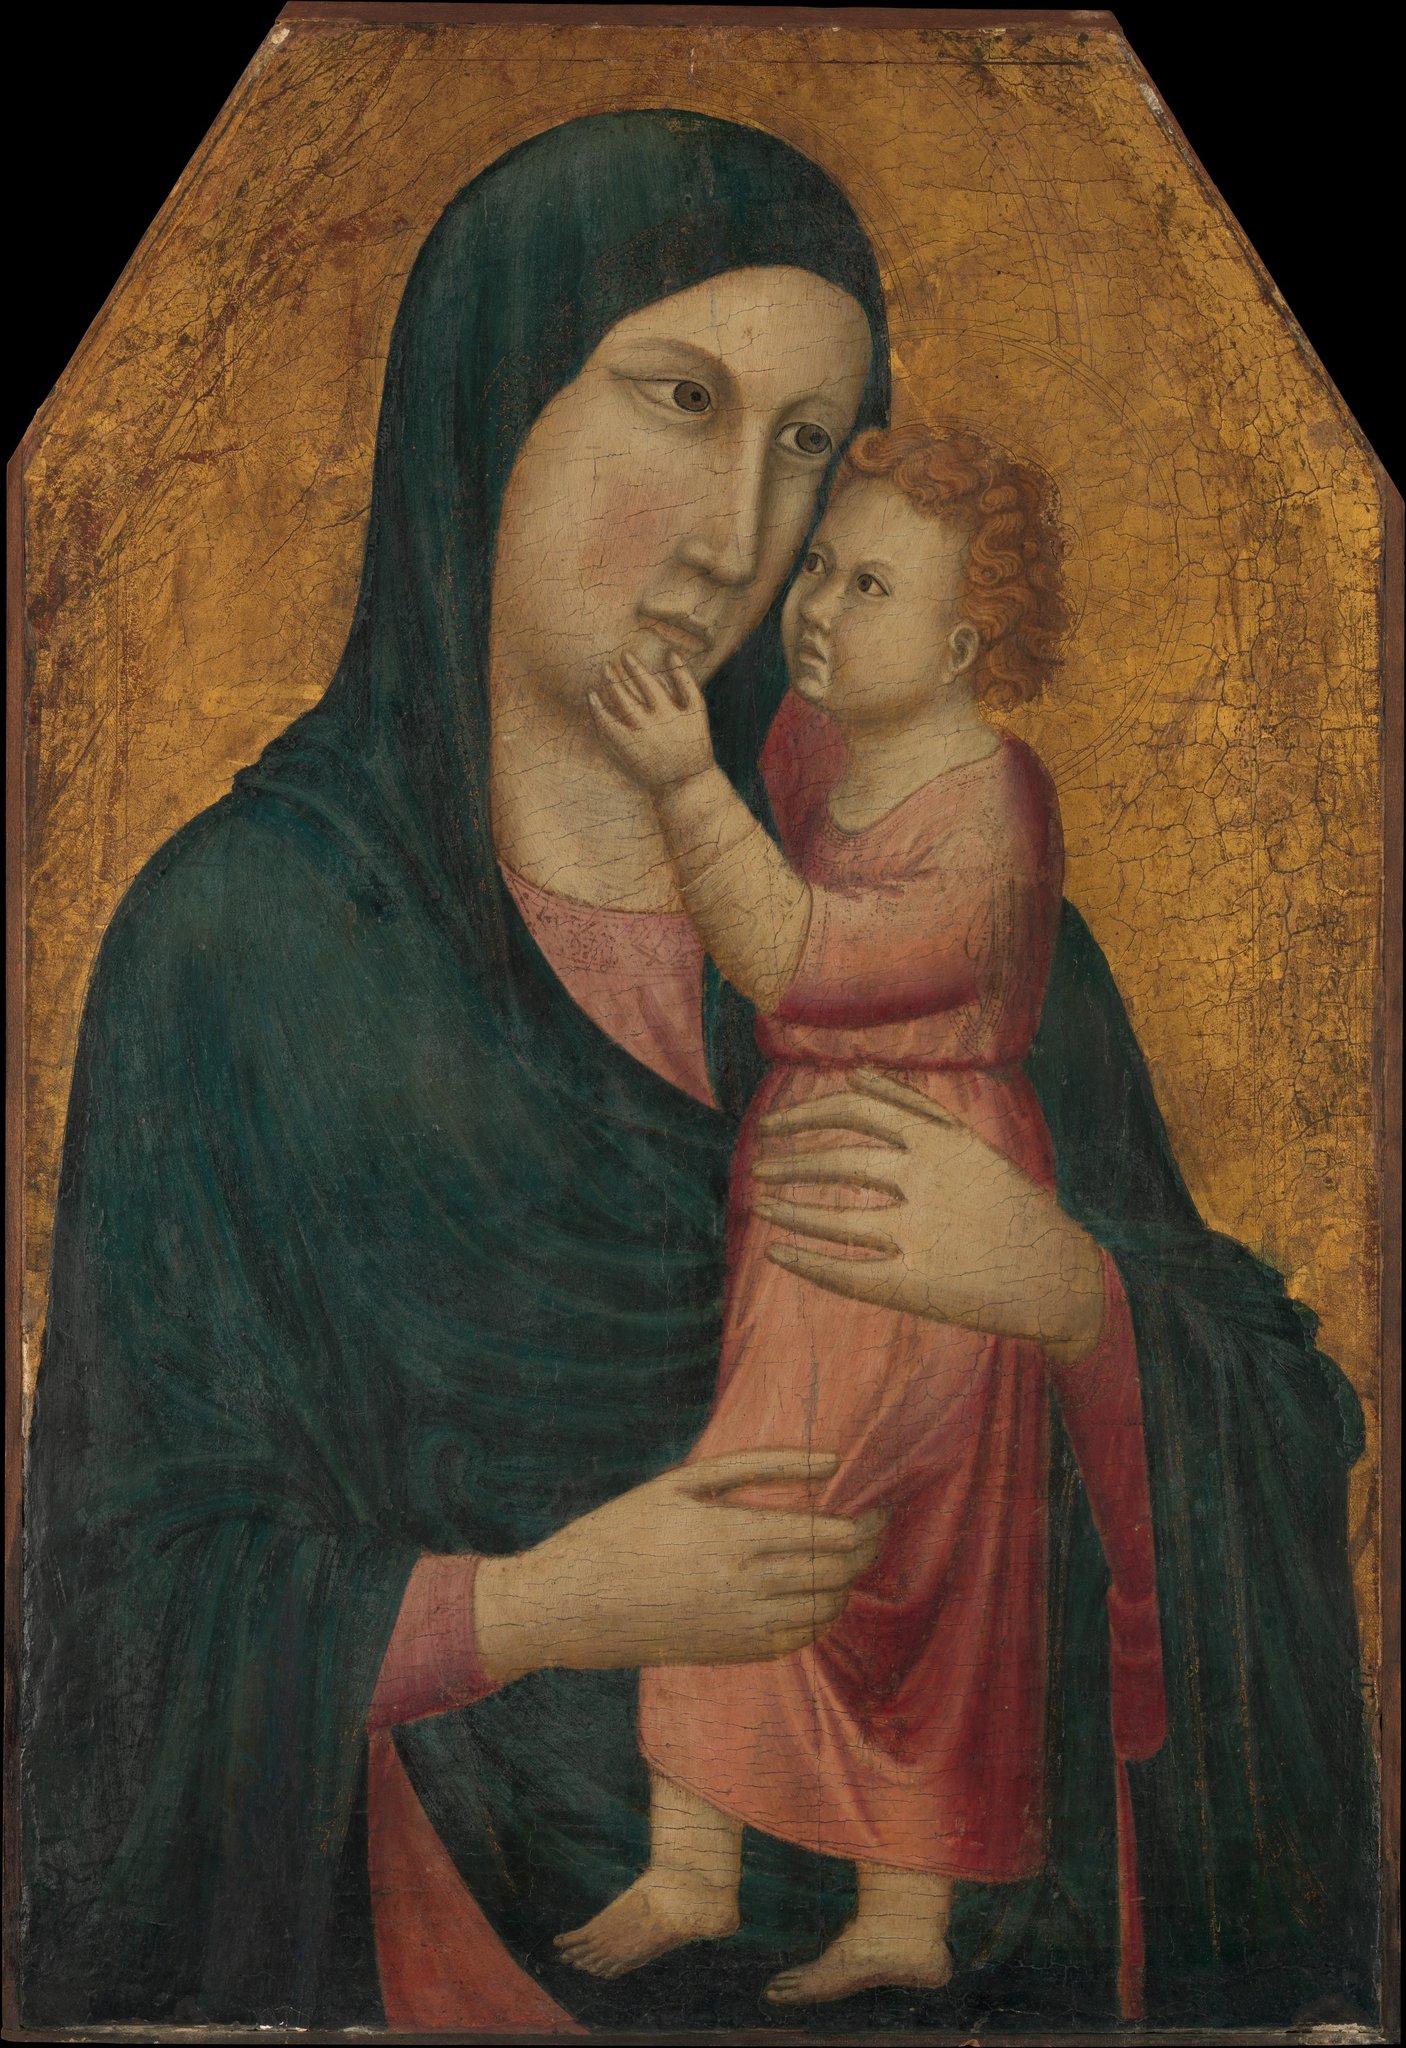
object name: painting fragment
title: Madonna and Child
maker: italian (florentine or paduan) painter (cheyo da firenze?)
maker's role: artist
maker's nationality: italian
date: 1307-1317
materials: gold leaf, paint, wood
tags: madonna and child